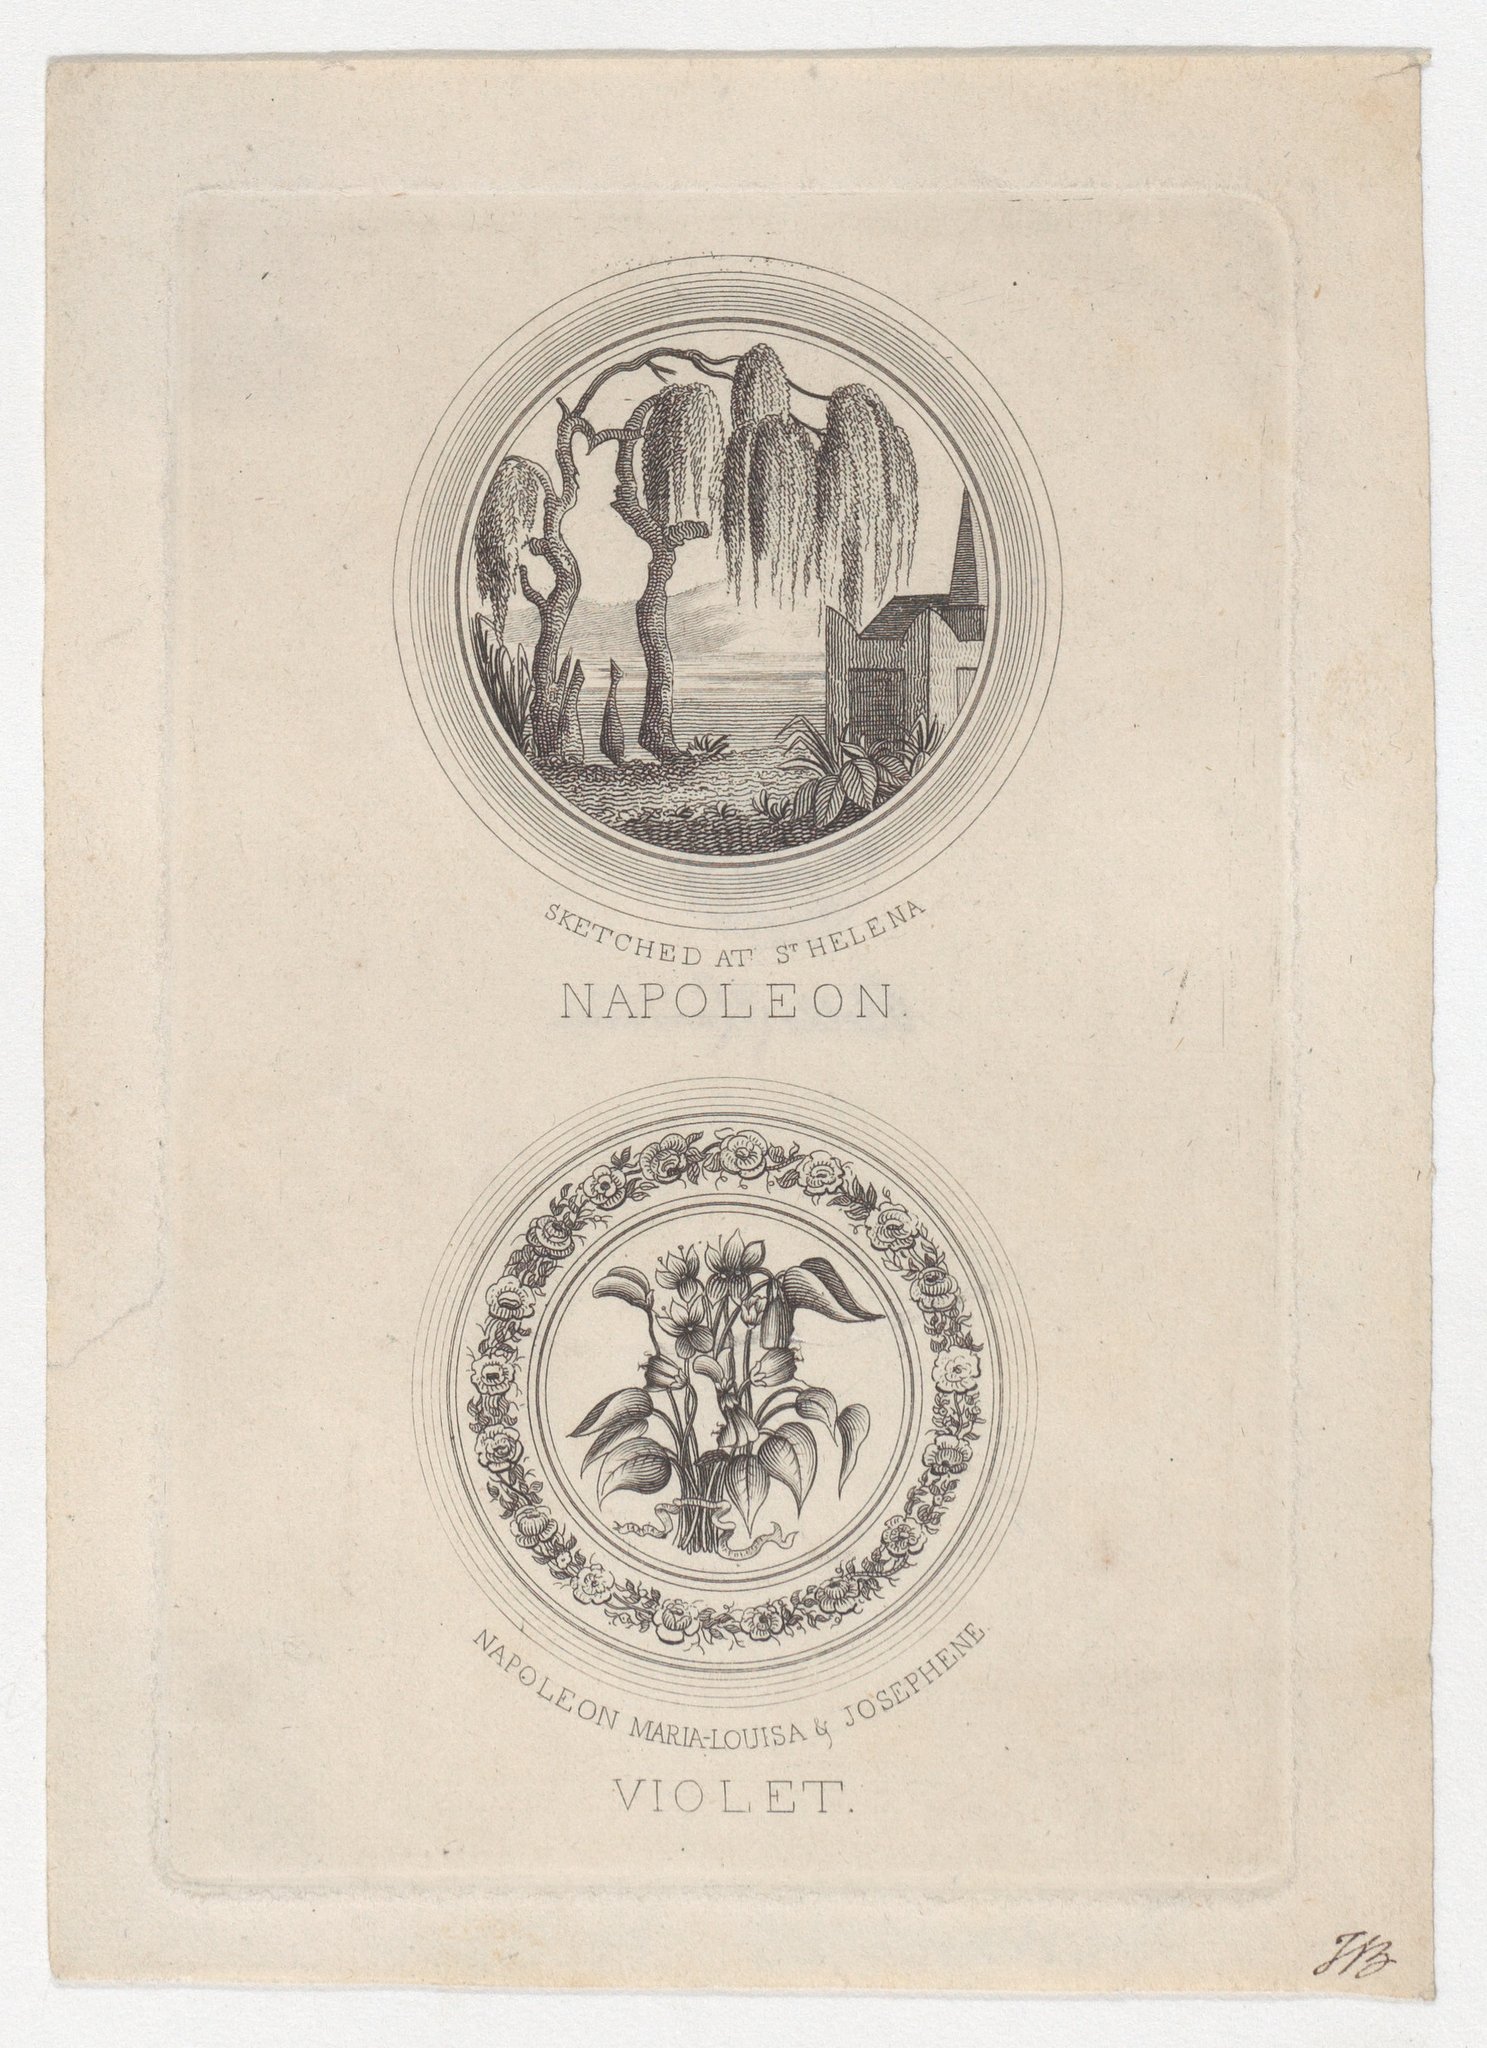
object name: print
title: The shade of Napoleon visiting his tomb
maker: Anonymous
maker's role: artist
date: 1831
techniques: lithograph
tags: napoleon i,flowers,trees